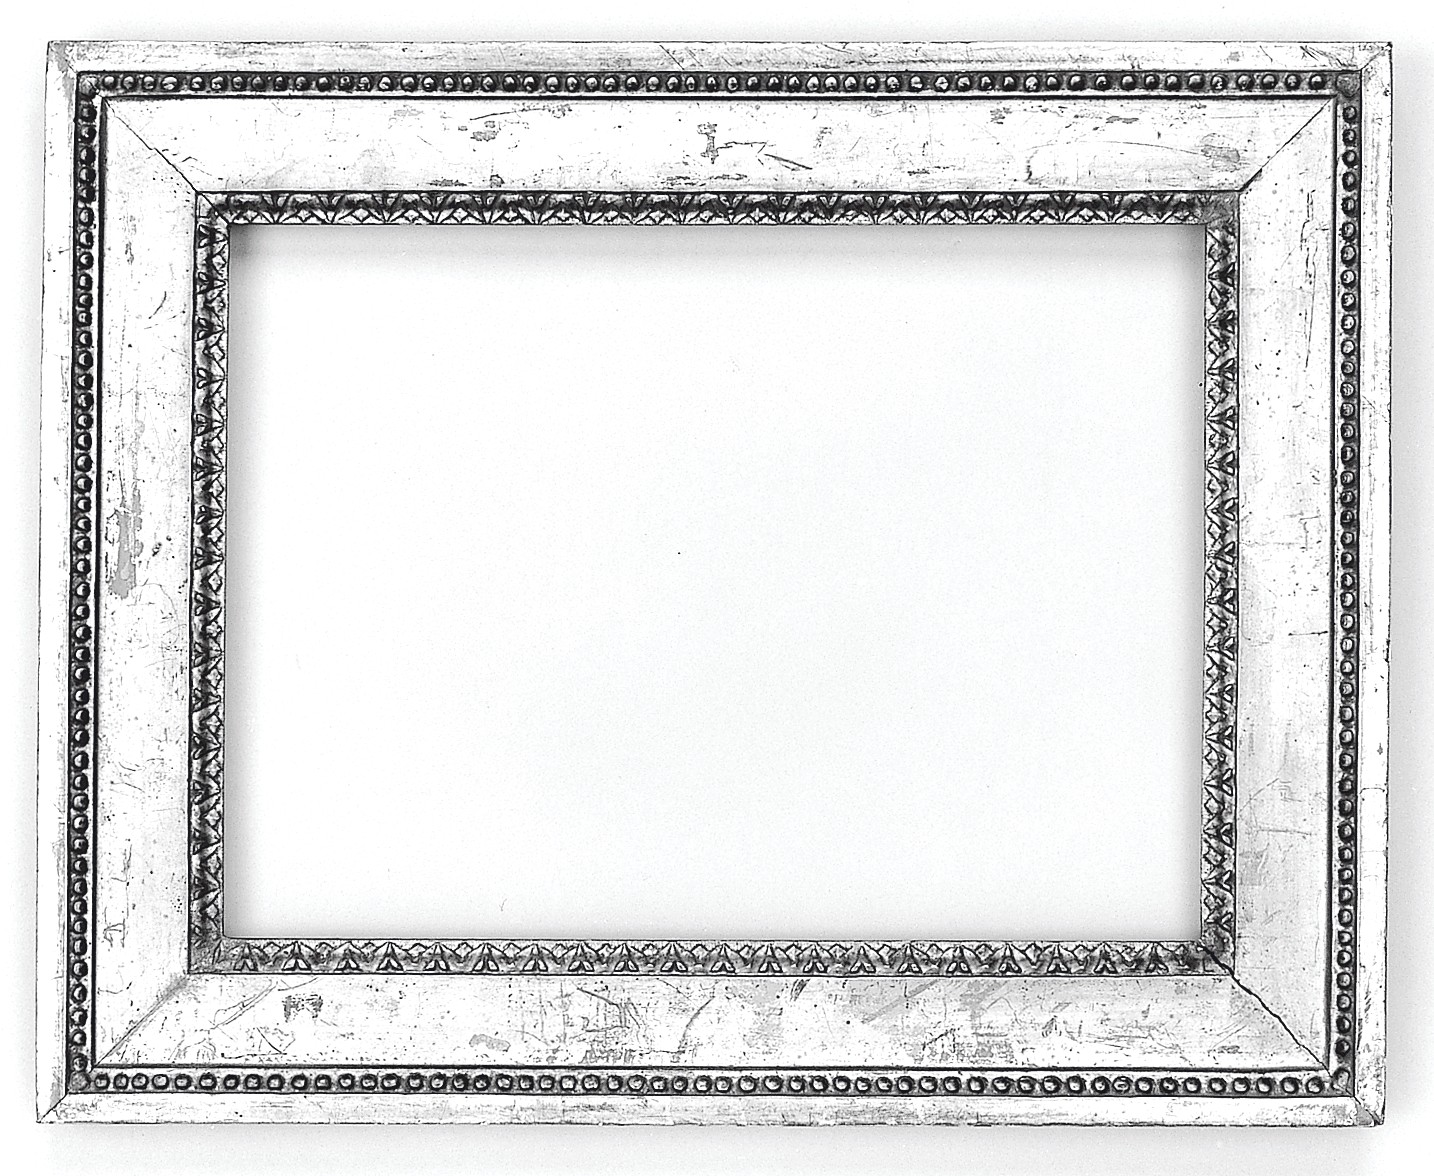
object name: frame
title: Cassetta frame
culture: french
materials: gilt, wood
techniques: carving